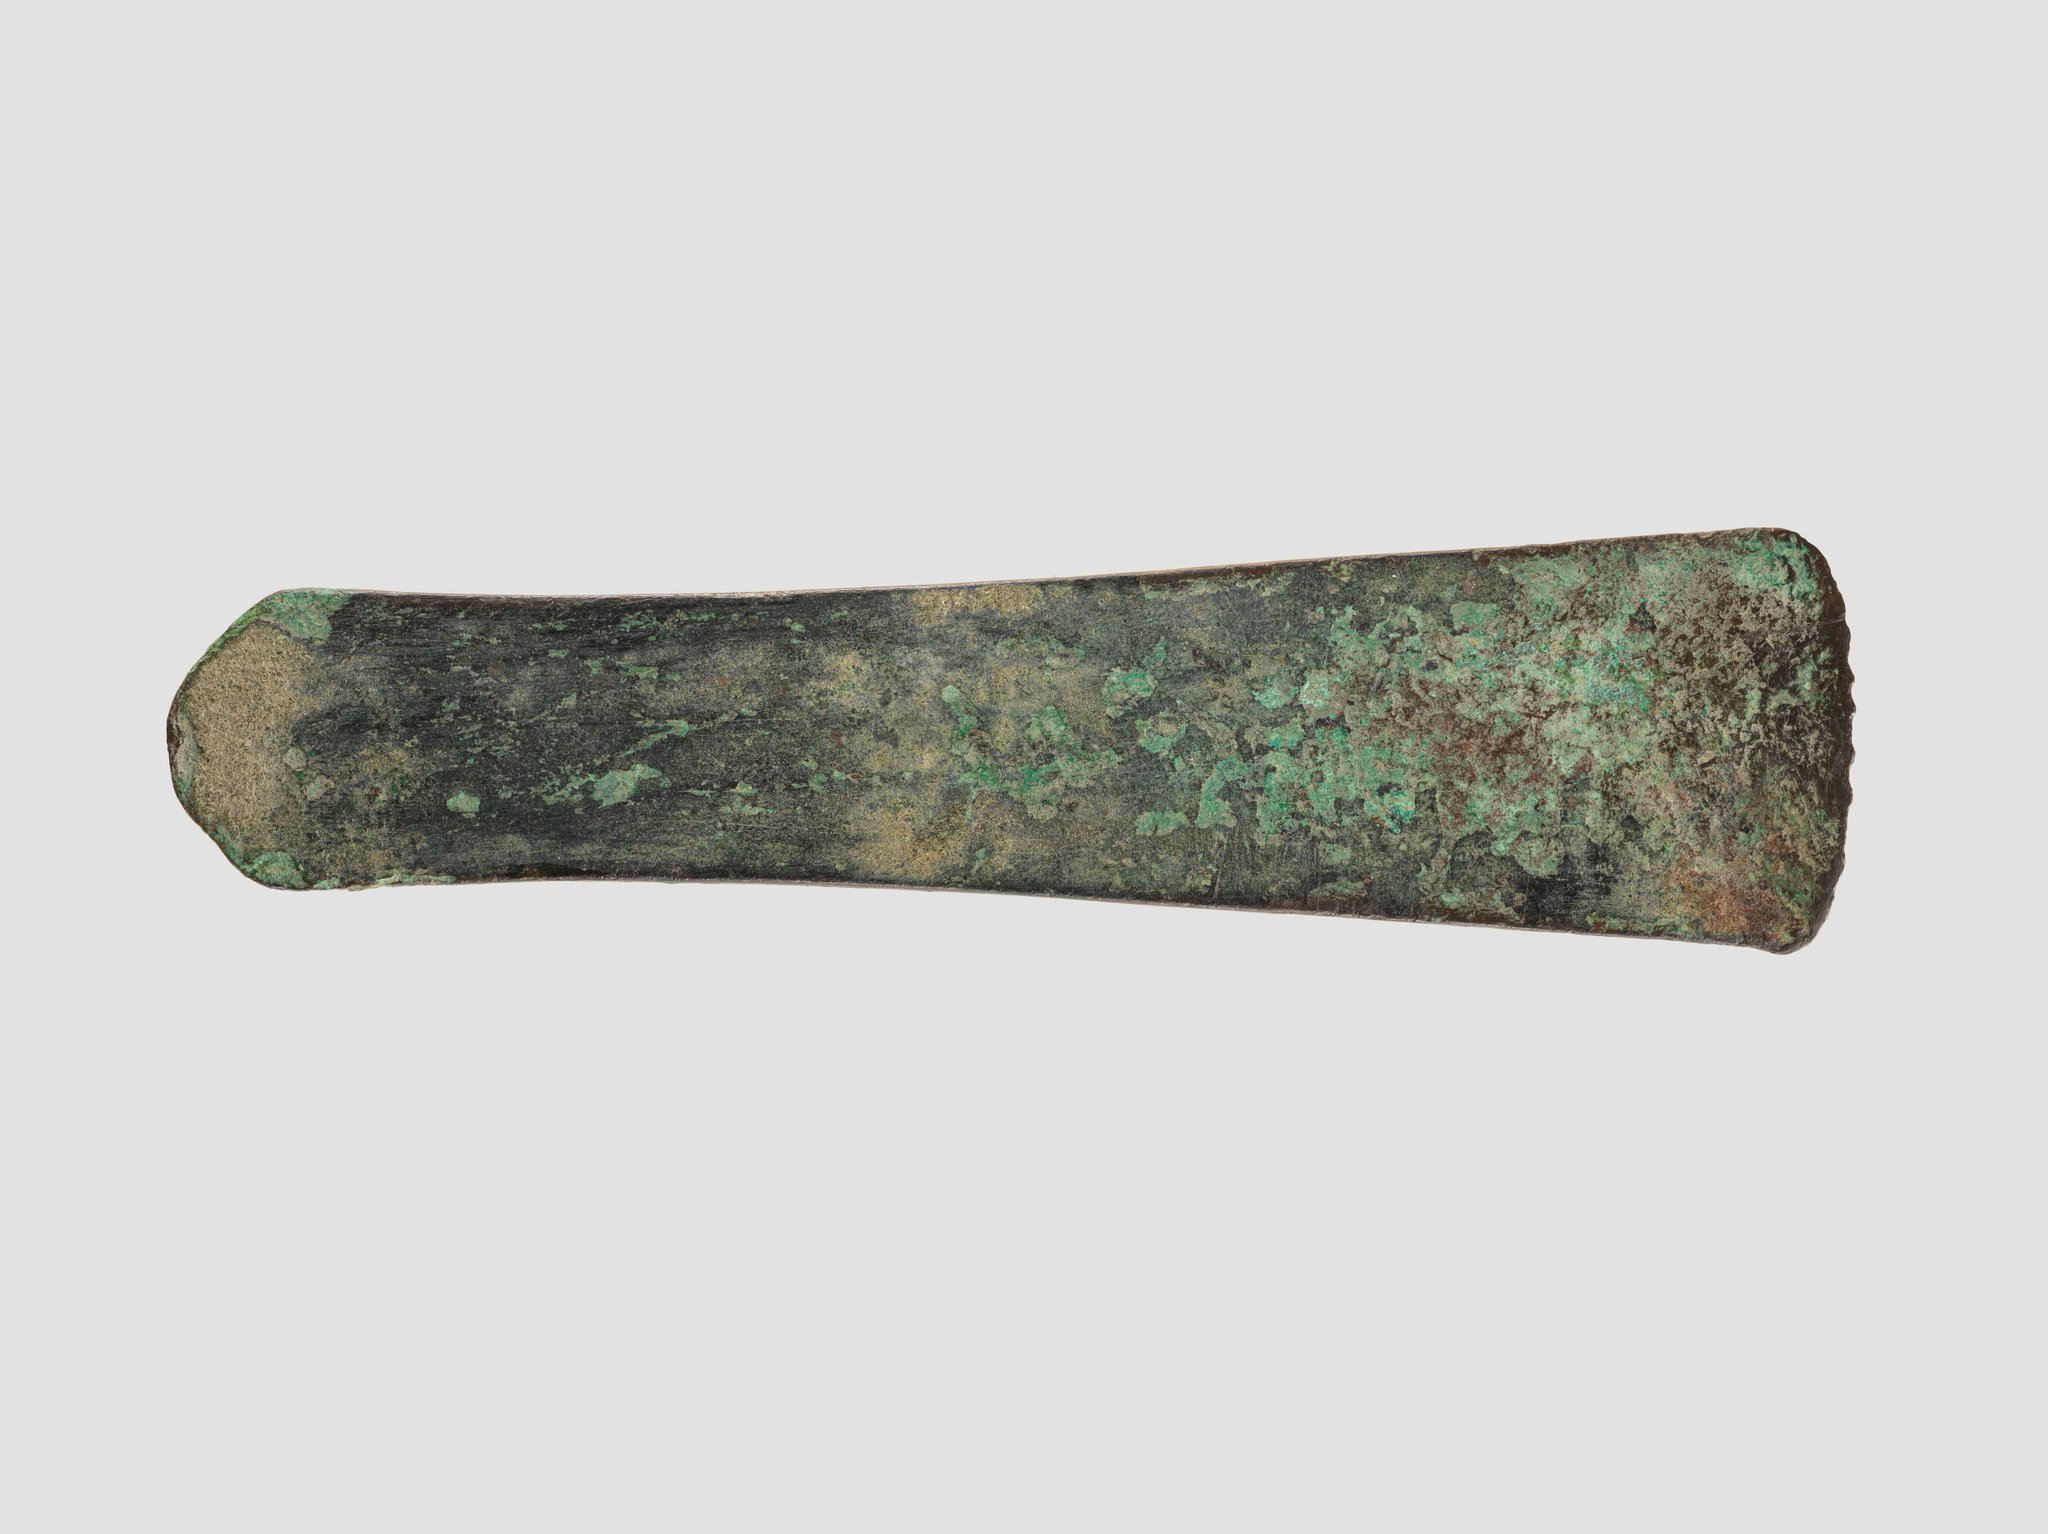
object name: adze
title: Adze head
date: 2000-1001 BCE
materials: bronze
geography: levant